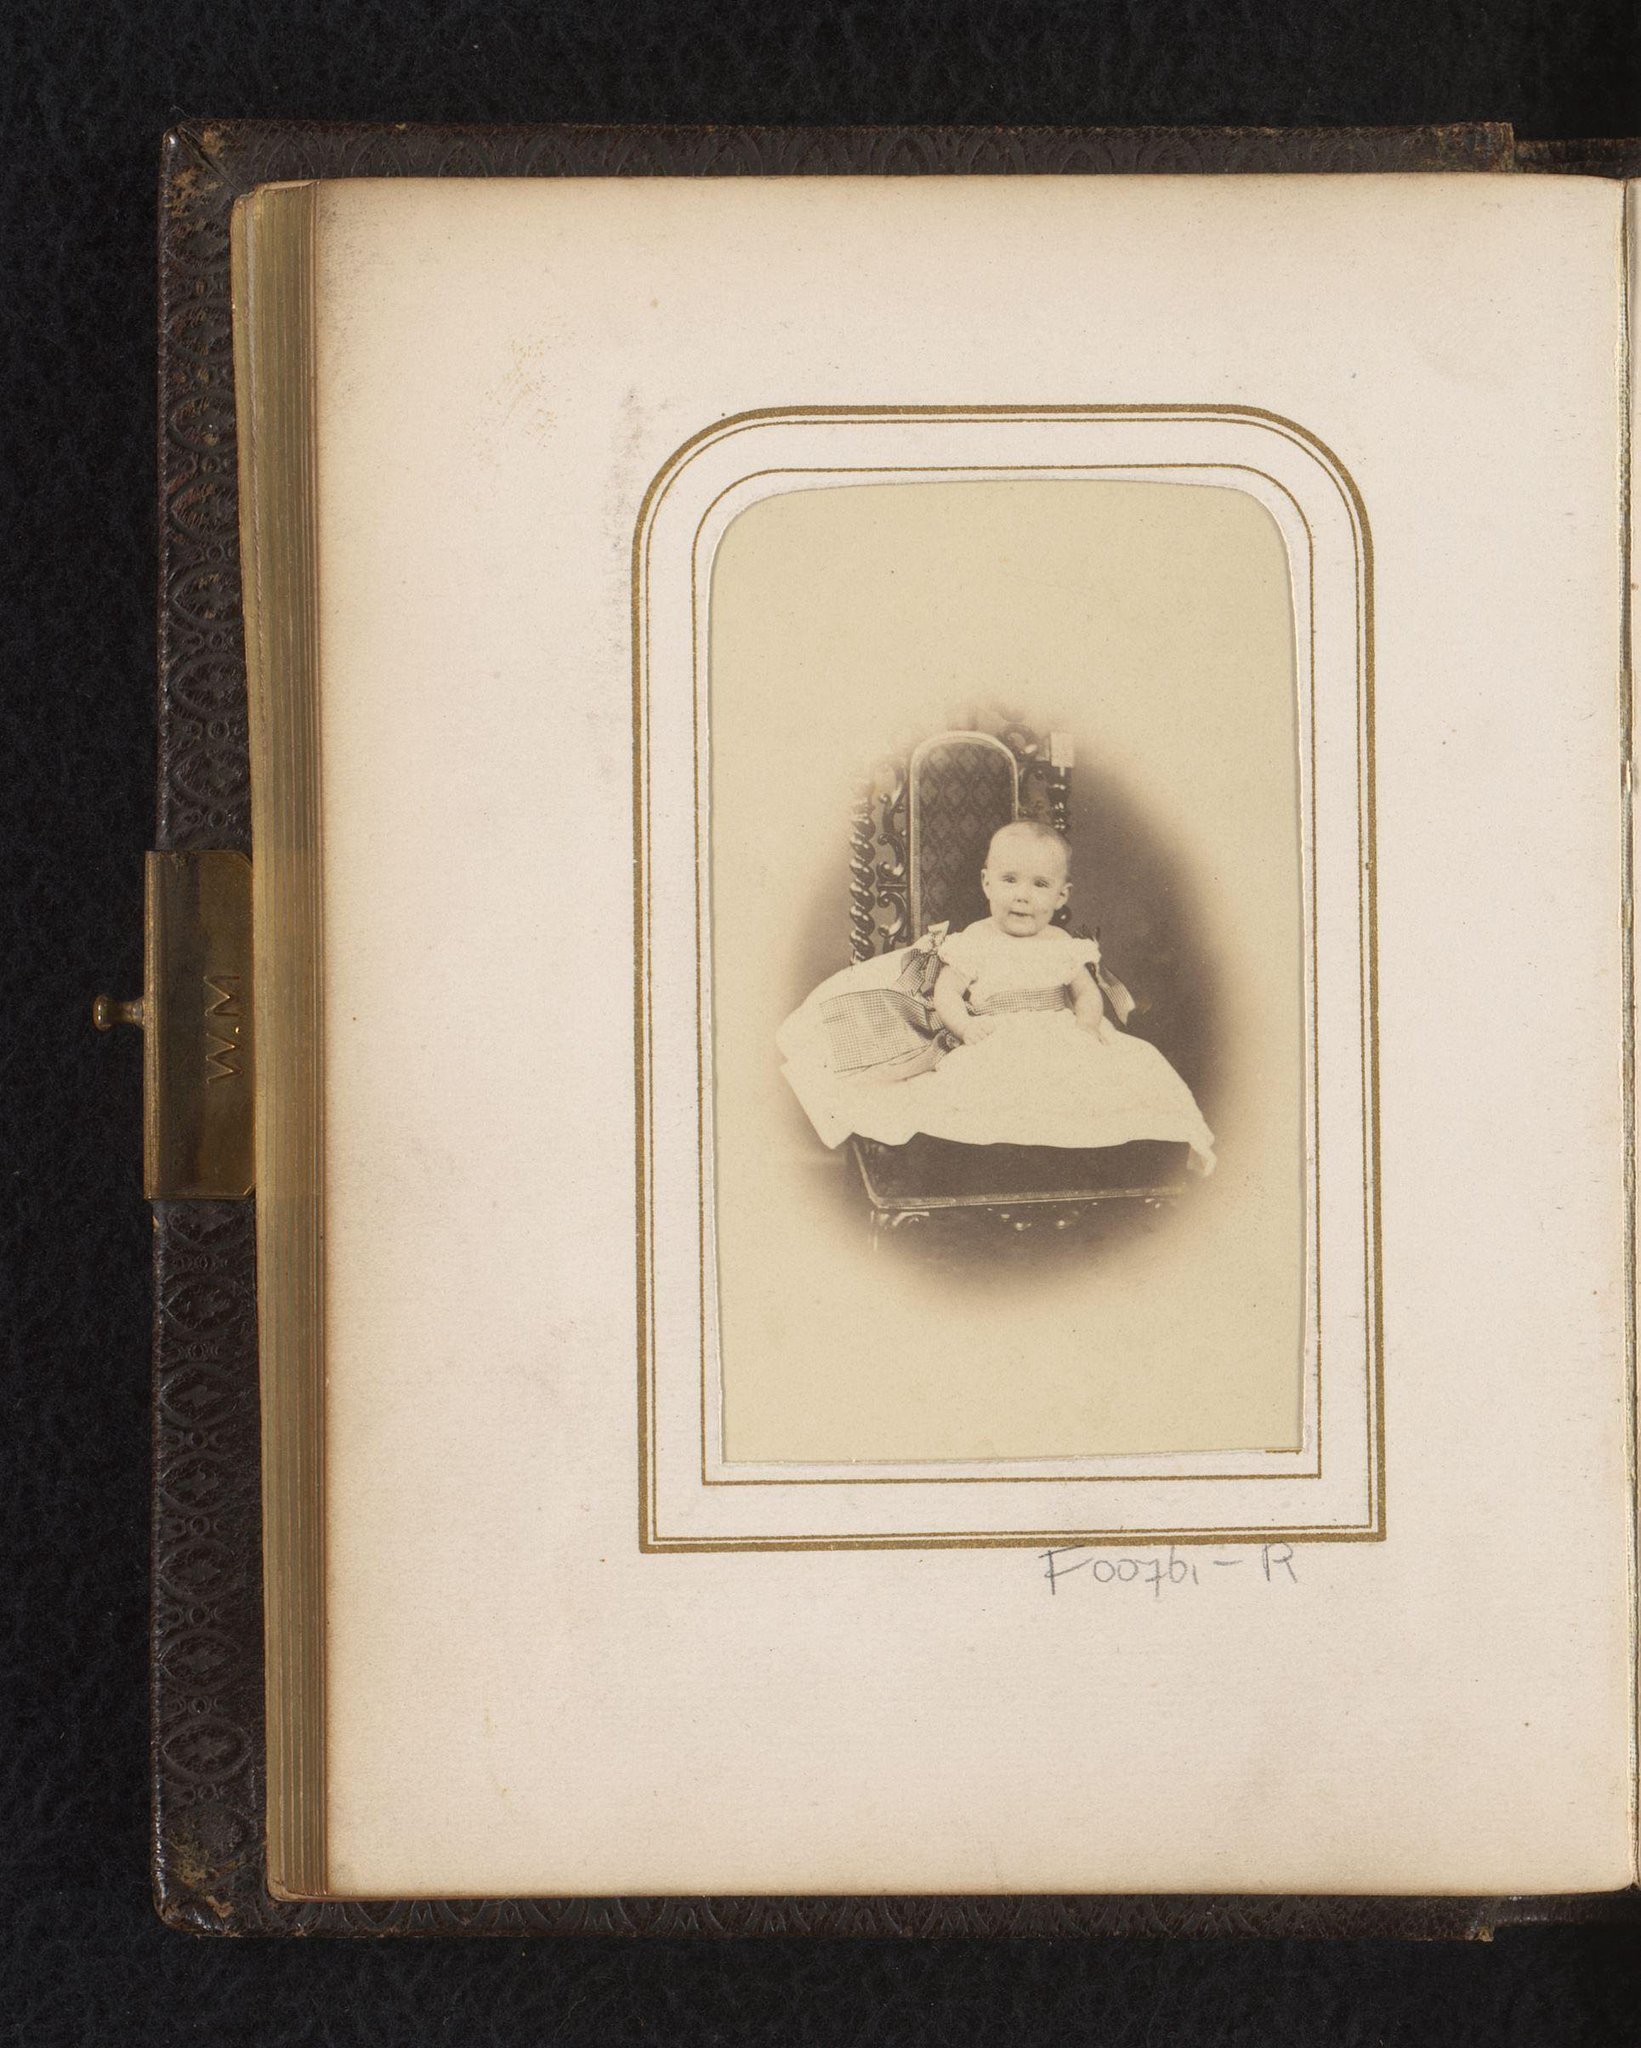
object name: album leaf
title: Portret van een baby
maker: g.e. nicholls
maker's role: fotograaf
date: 1860-1880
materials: cardboard, photographic support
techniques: albumen print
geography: edmonton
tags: infant, baby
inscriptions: inscription: ‘G.E. Nicholls/ Photographer/ Fore St./ Edmonton’